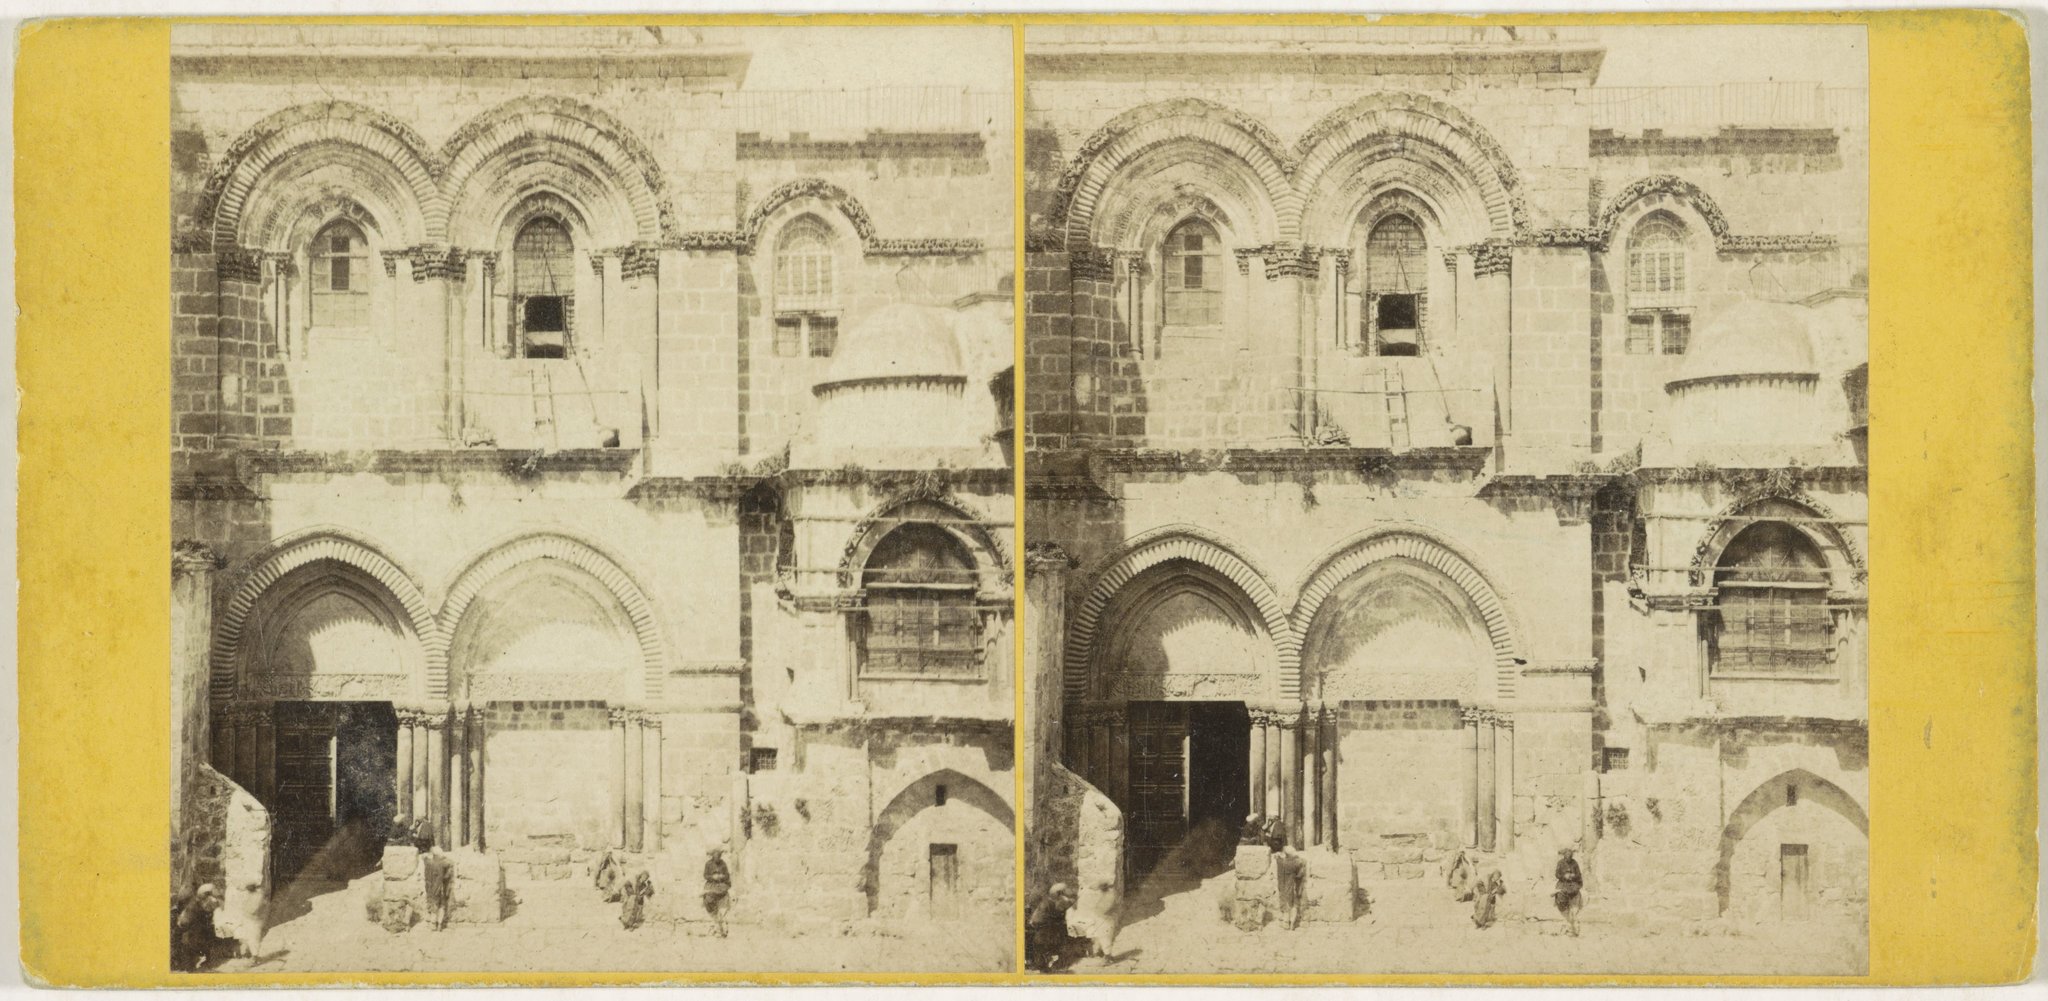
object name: stereograph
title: Jerusalem. - The Church of the Holy Sepulchre / Jérusalem. - Église du St. Sépulchre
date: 1860-1880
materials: cardboard, paper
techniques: albumen print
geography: heilig grafkerk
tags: gate, entrance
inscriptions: number: ‘No. 283.’